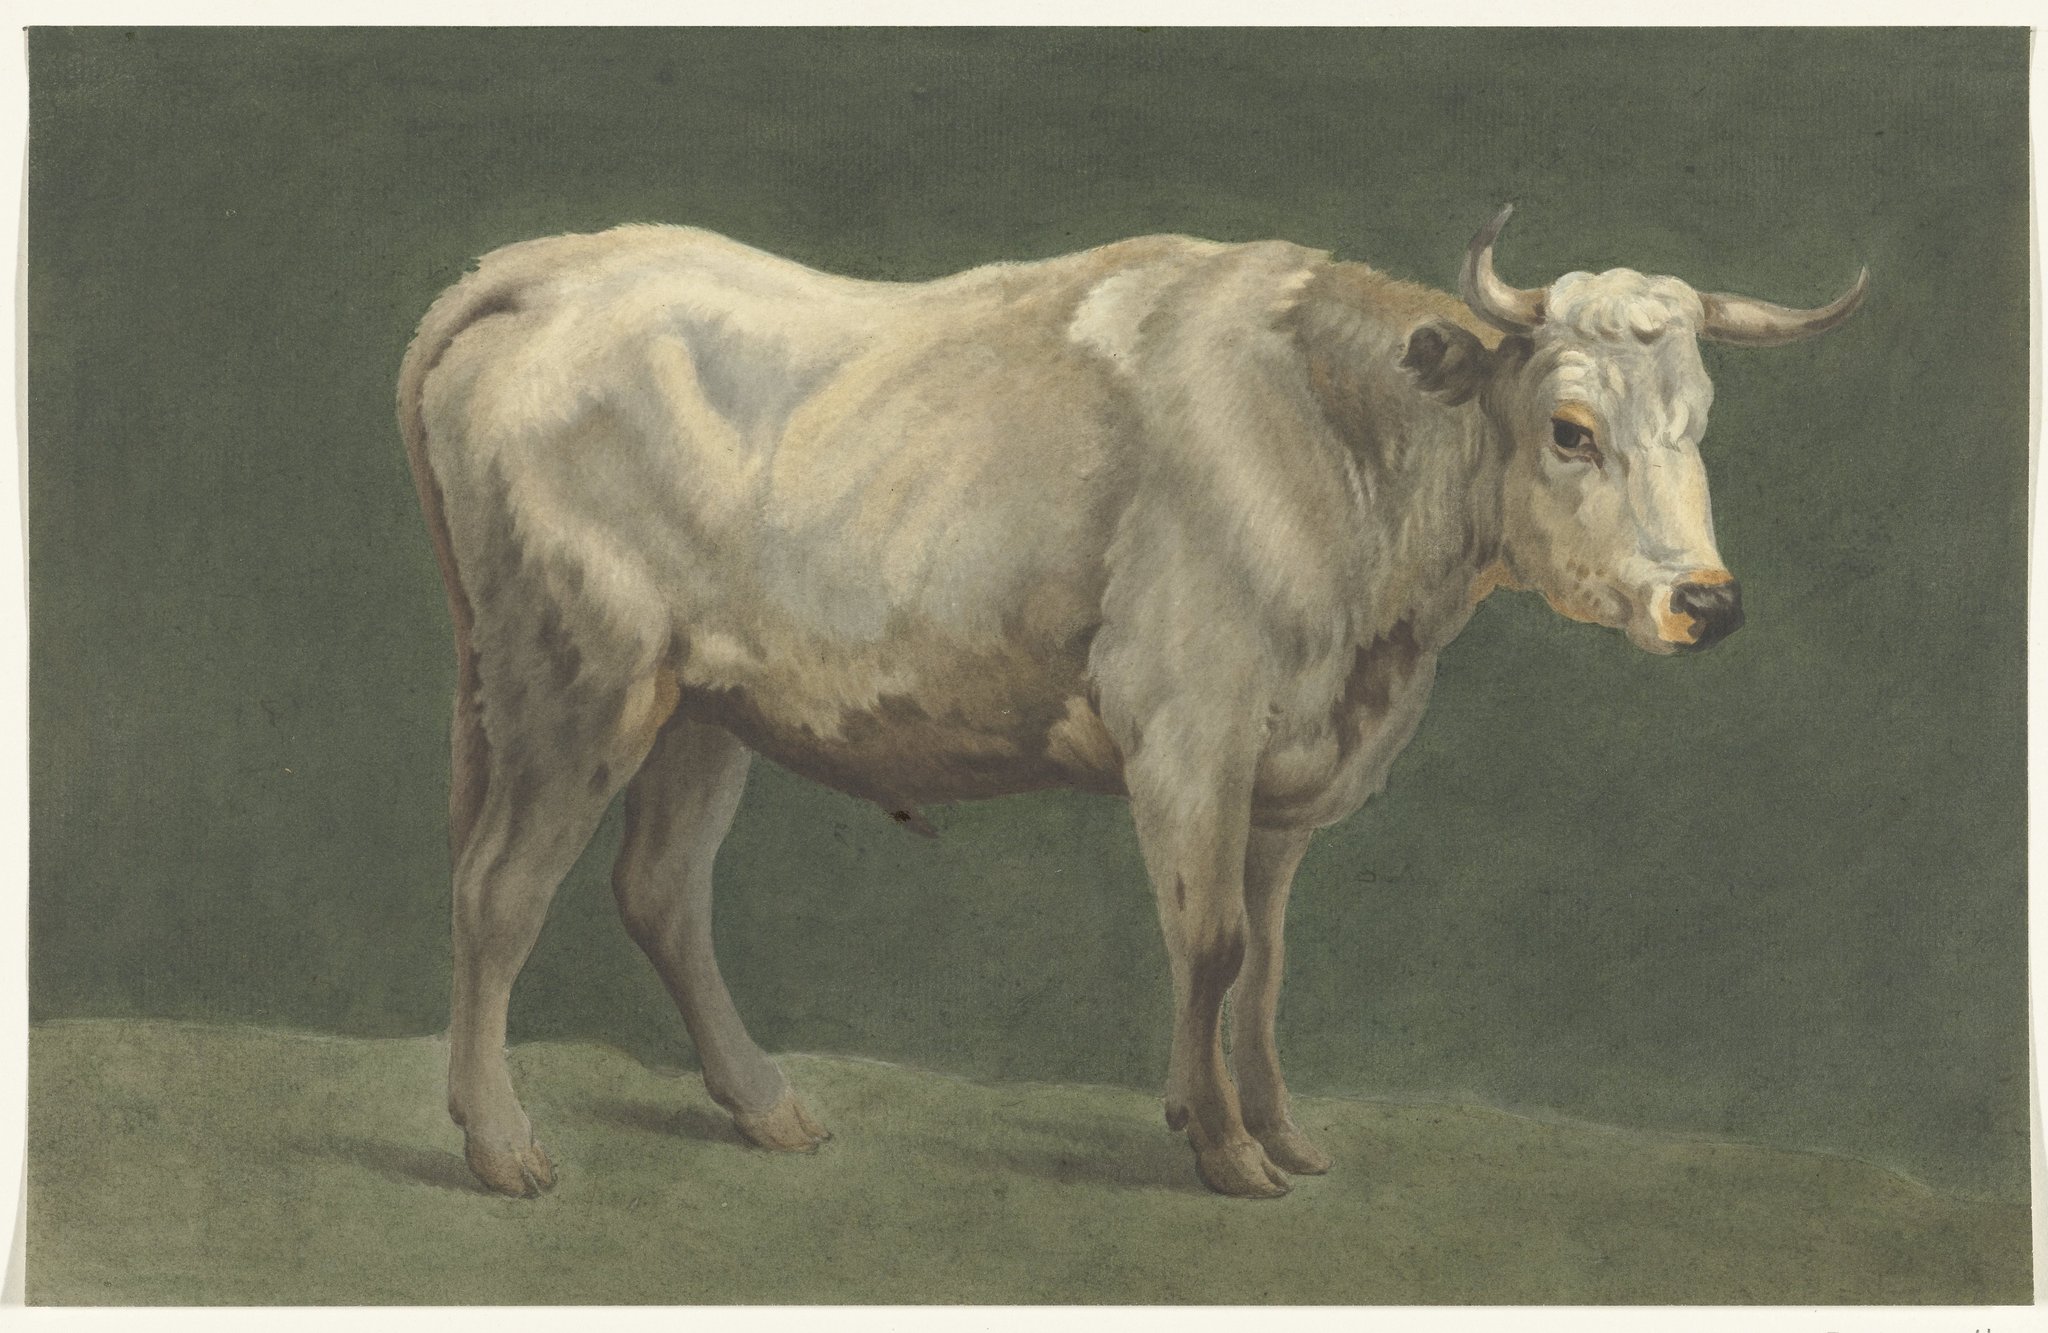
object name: drawing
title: Staande stier, naar rechts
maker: jean bernard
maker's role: draughtsman, print maker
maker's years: 1765-1833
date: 1775-1833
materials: paper, watercolor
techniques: brush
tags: bull